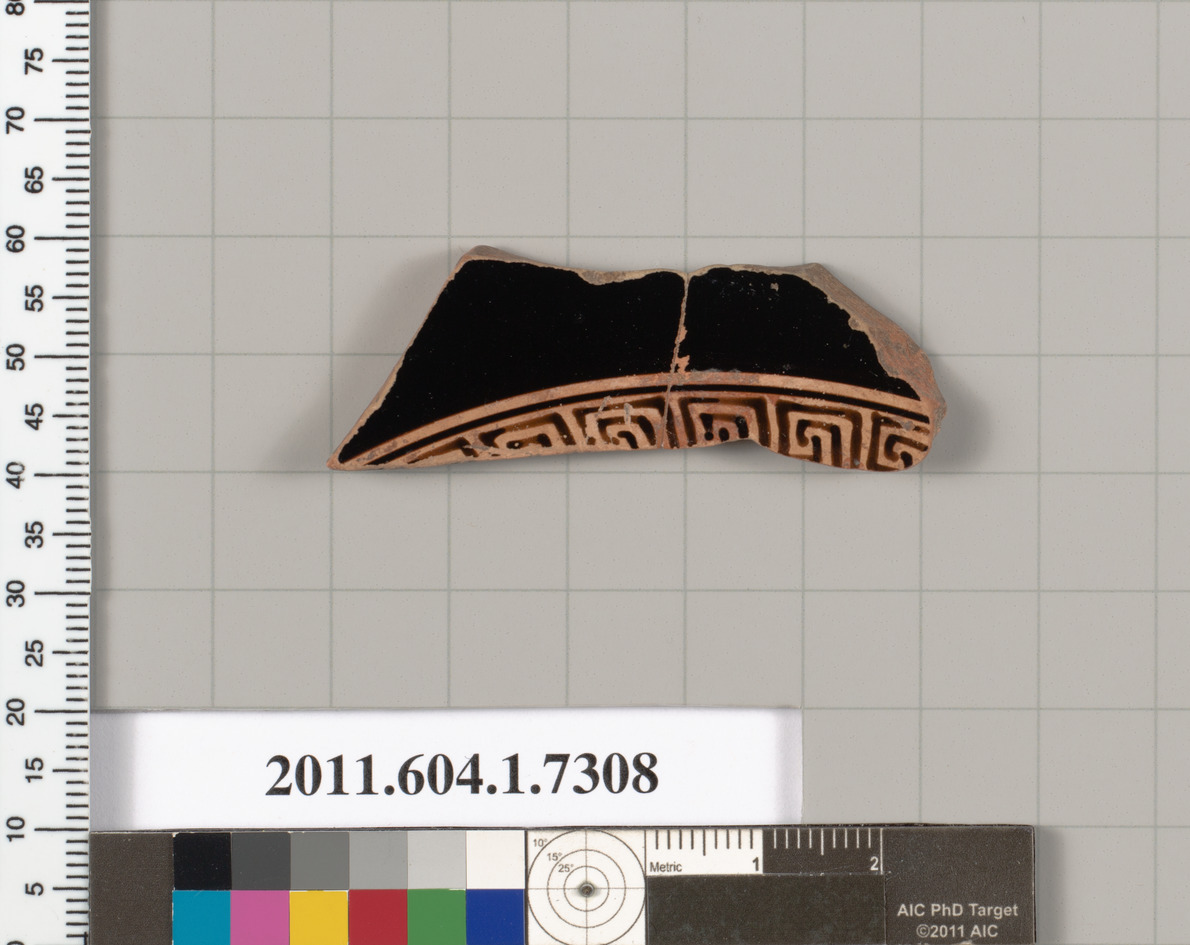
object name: kylix fragment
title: Terracotta fragment of a kylix (drinking cup)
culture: greek, attic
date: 500-480 BCE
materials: terracotta